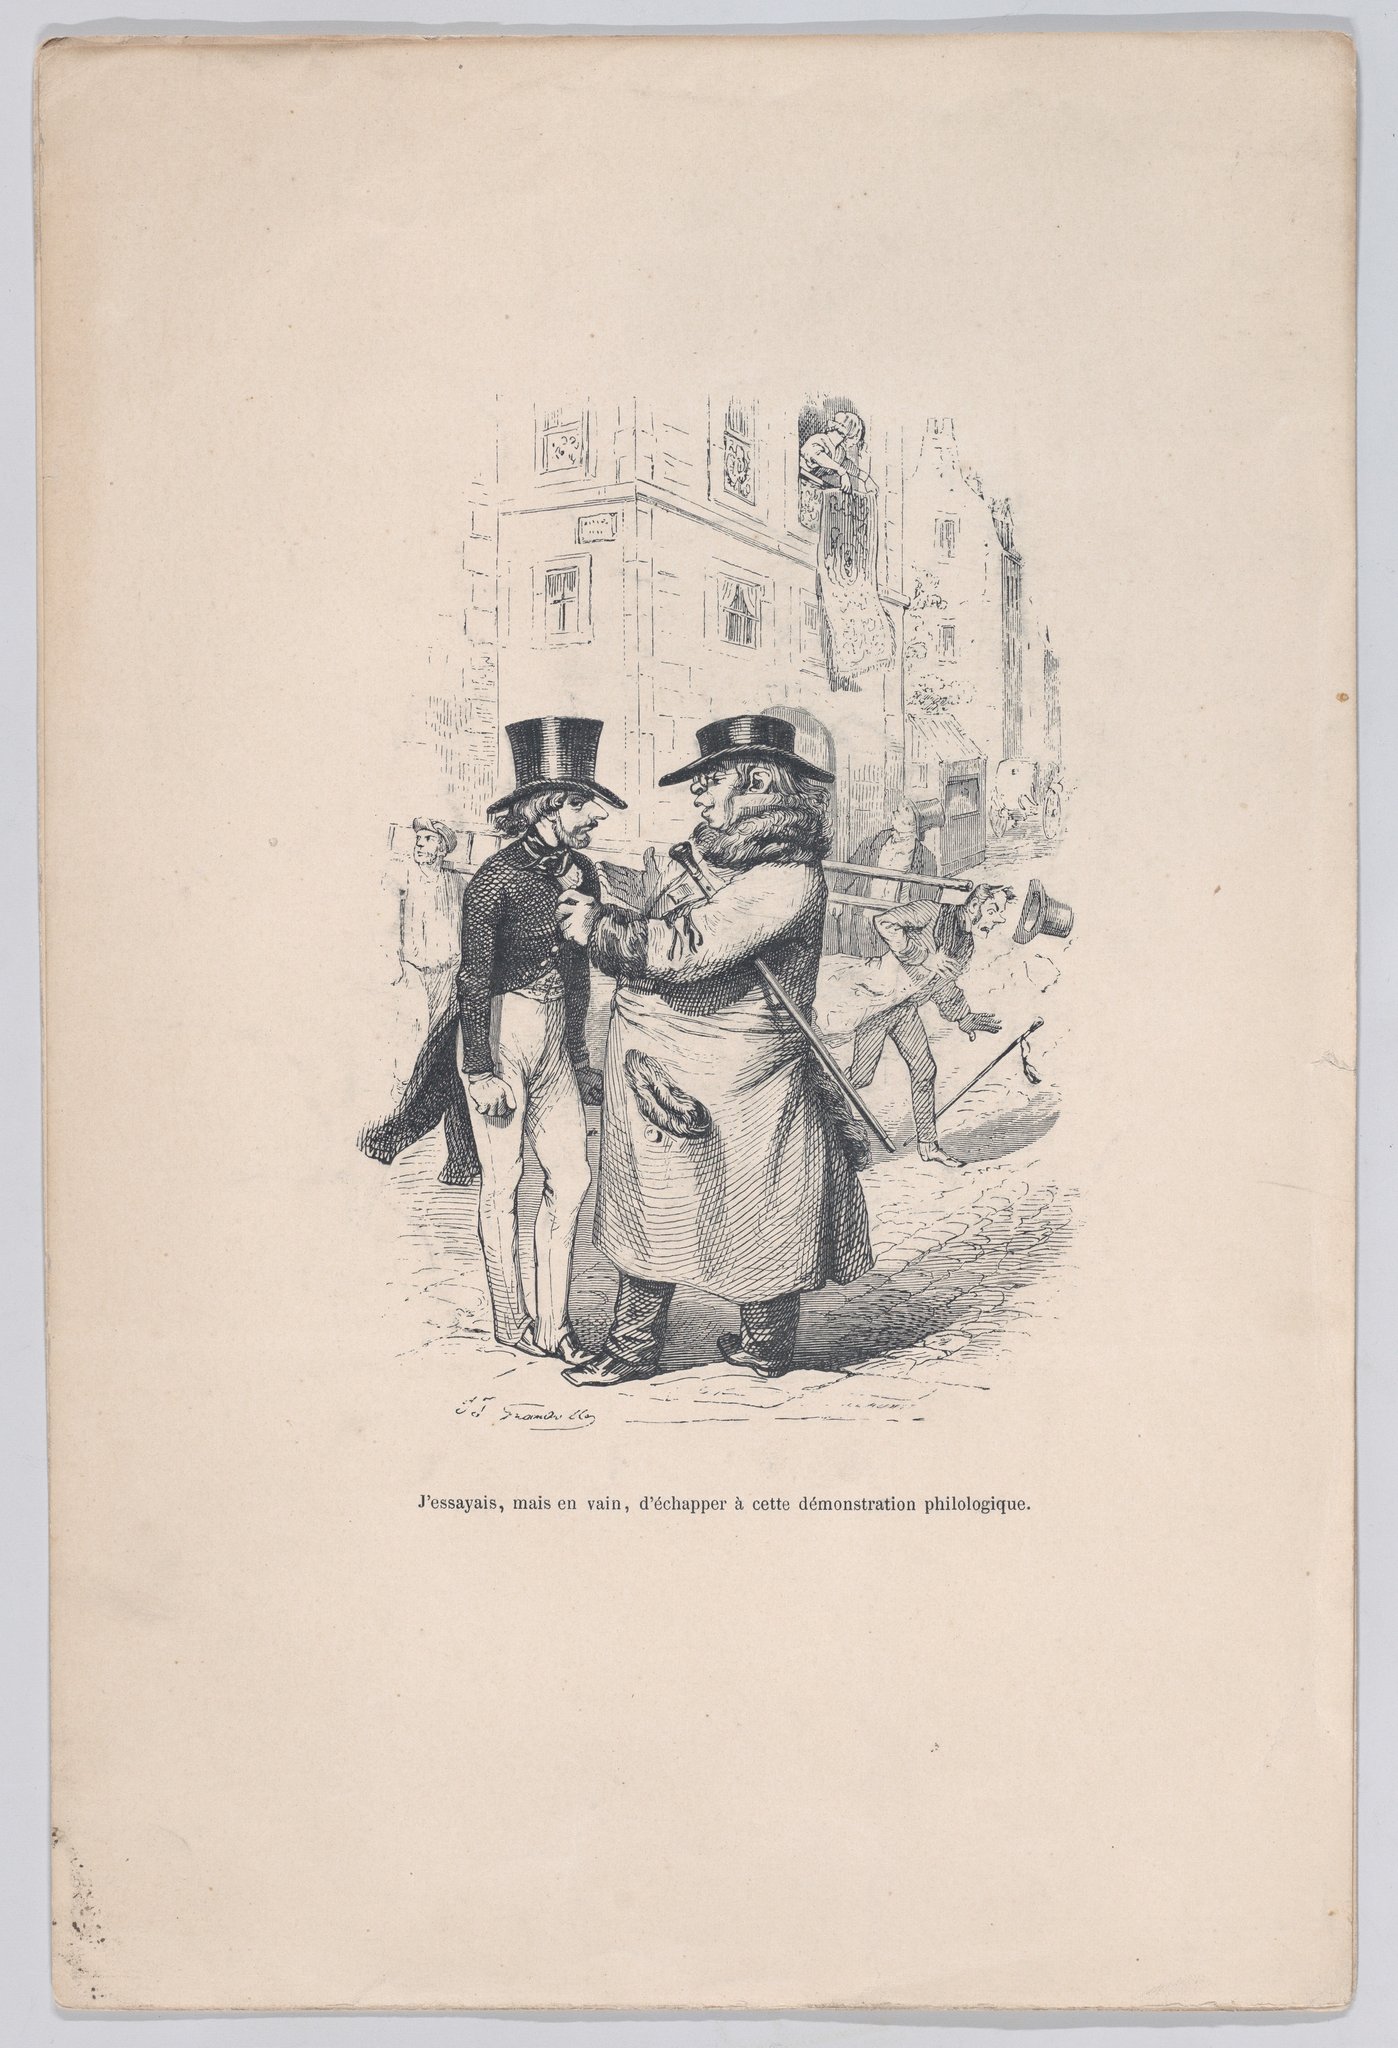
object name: print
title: I tried to escape from this philological discussion, from "Little Miseries of Human Life"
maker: j. j. grandville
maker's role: illustrator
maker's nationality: french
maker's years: 1803-1847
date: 1843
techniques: engraving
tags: men